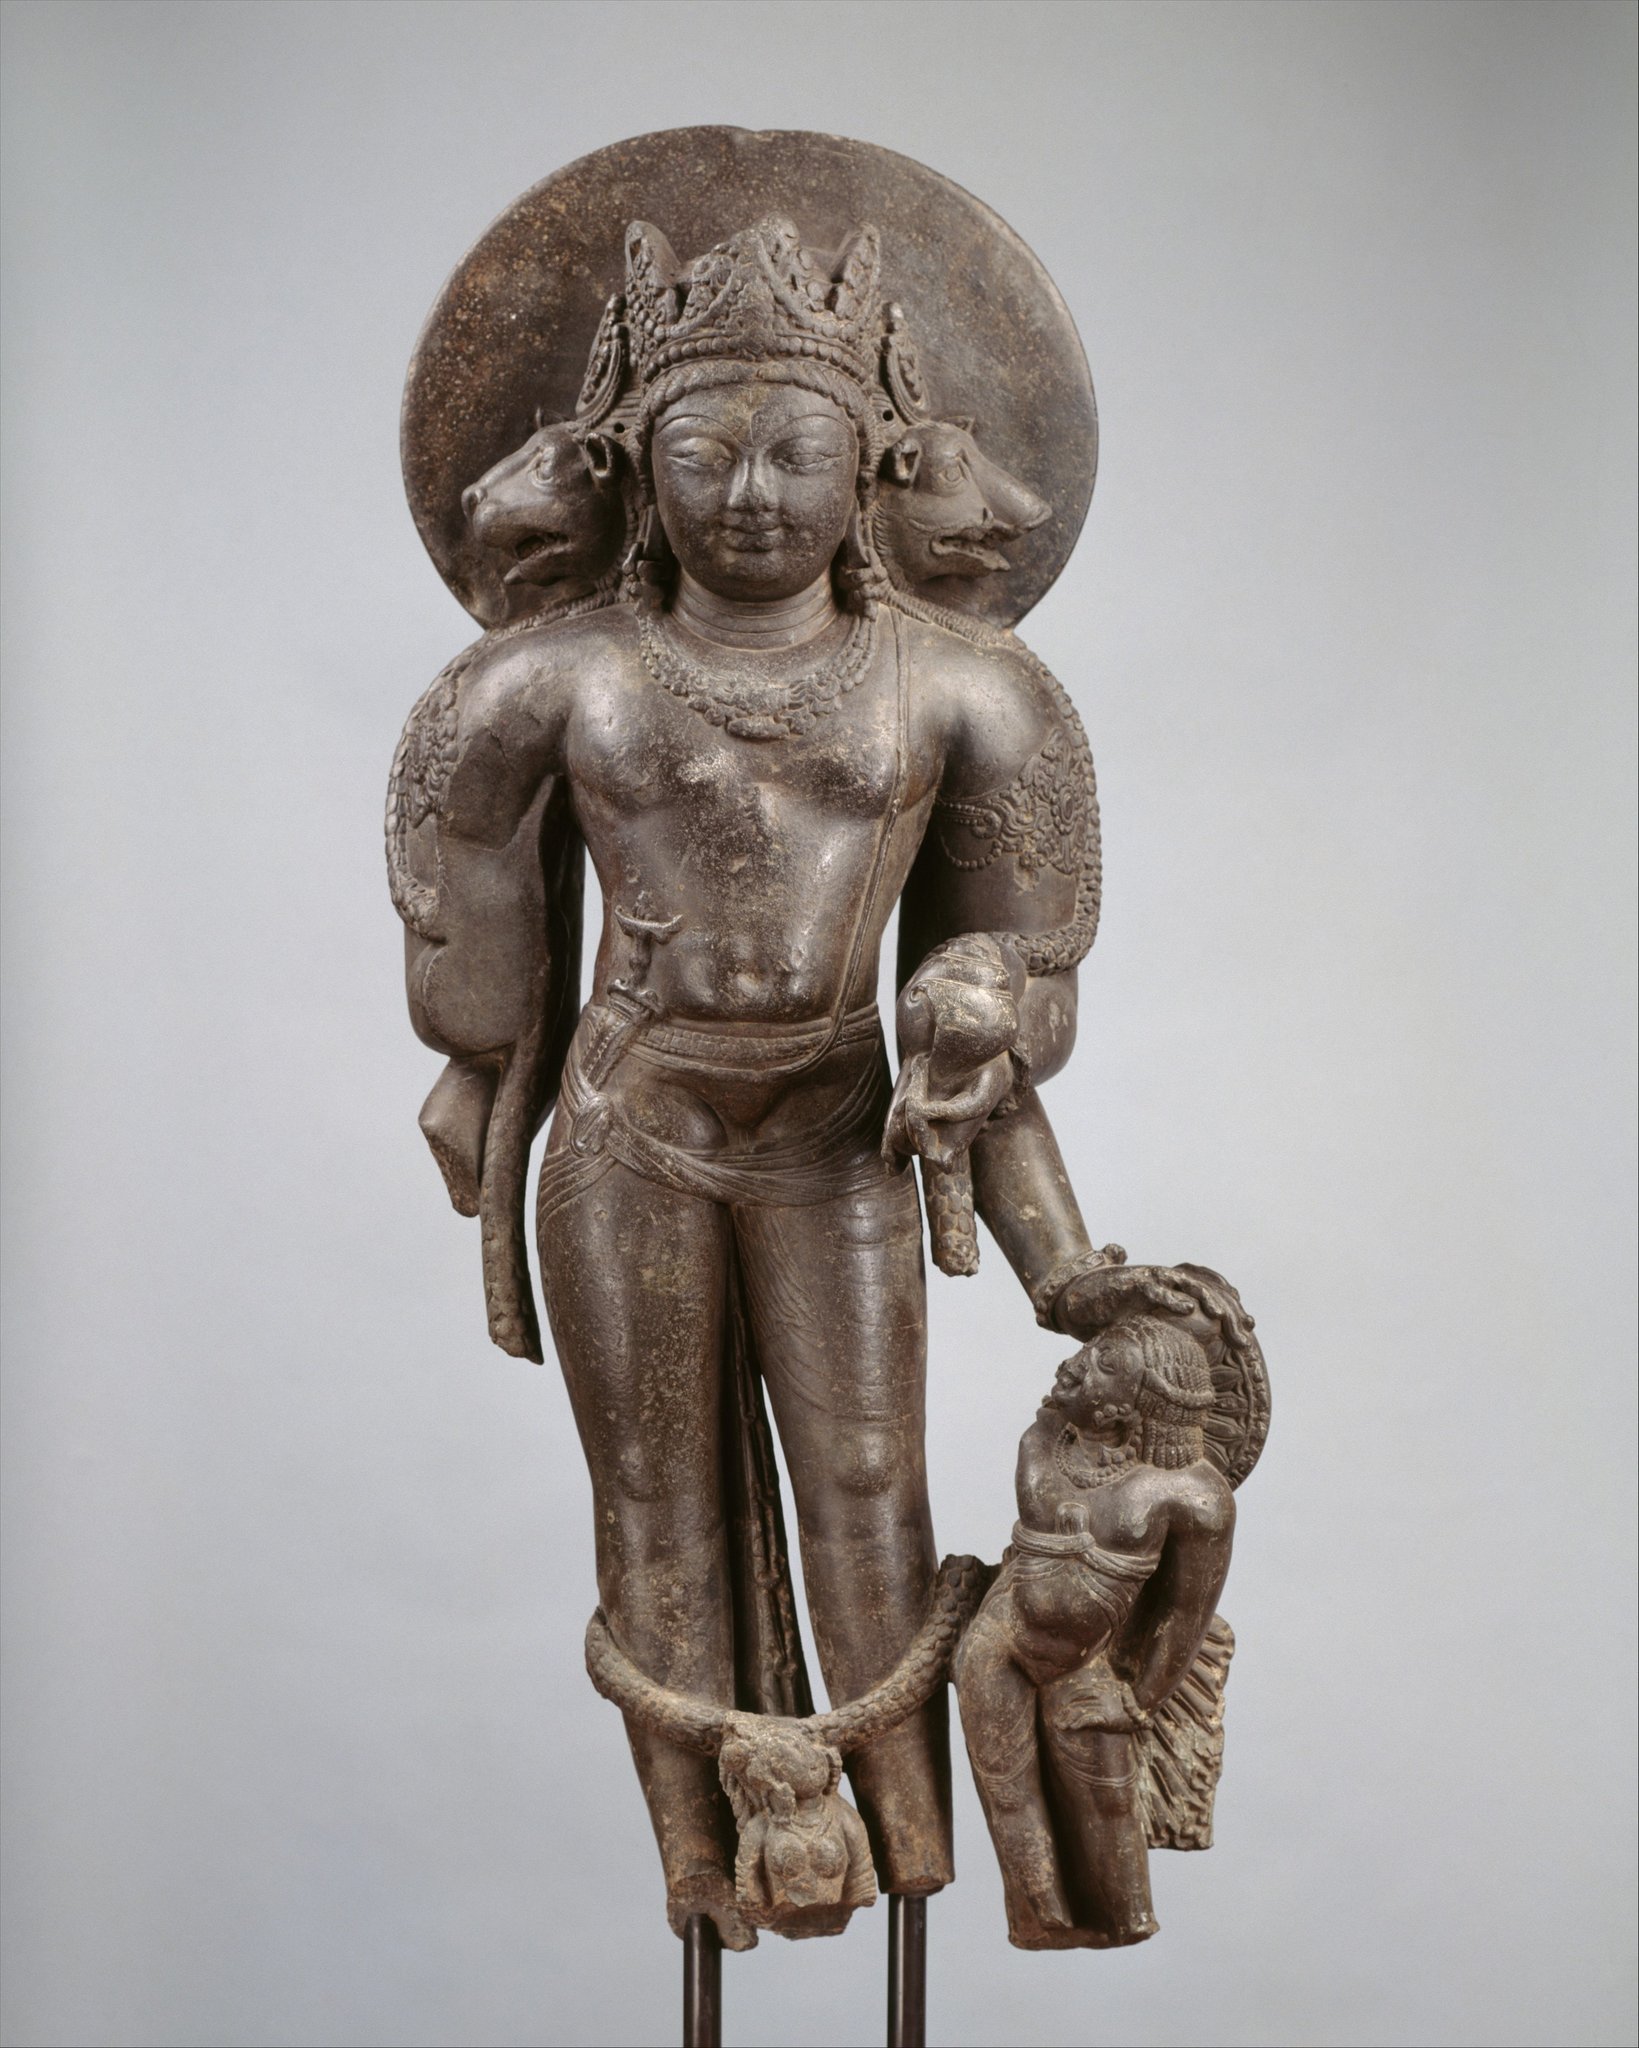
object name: figure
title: Vaikuntha Vishnu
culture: kashmiri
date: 776-800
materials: stone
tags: kashmir,vishnu,hinduism